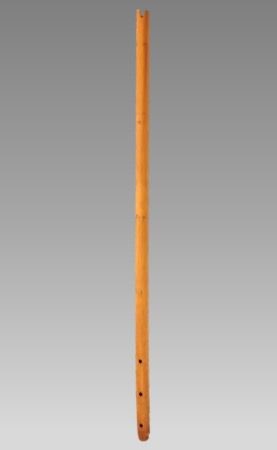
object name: rura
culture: melanesian, aoba island or vanuatuan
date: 1867-1900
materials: bamboo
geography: vanuatu